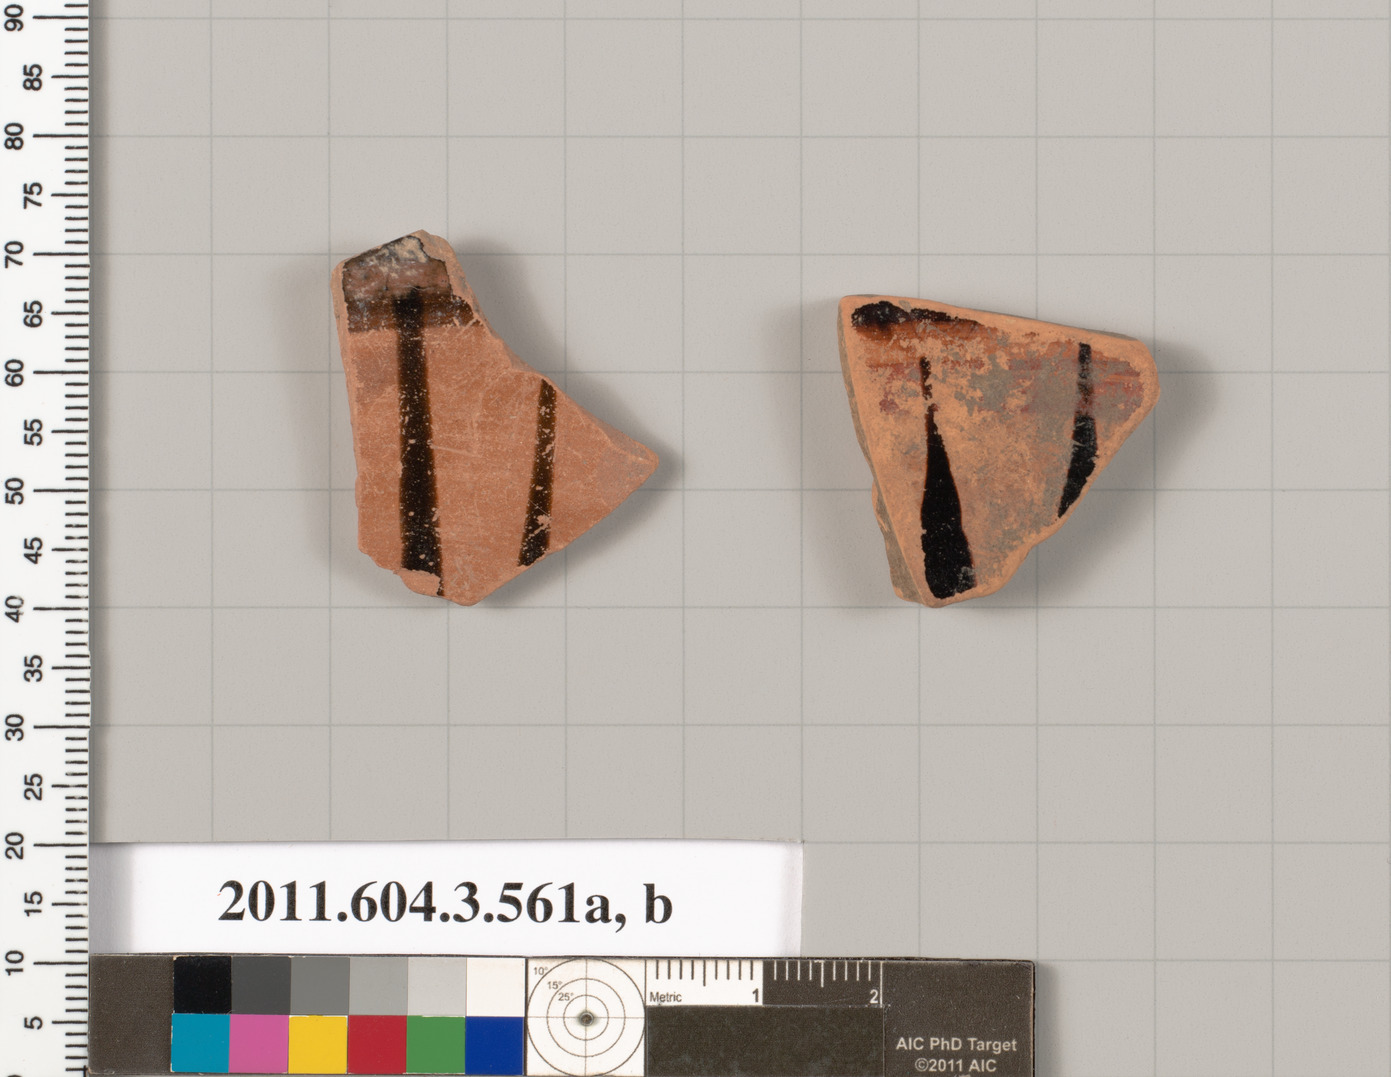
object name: column krater fragment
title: Terracotta fragments of column-kraters (bowls for mixing wine and water)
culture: greek, attic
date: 600-401 BCE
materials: terracotta